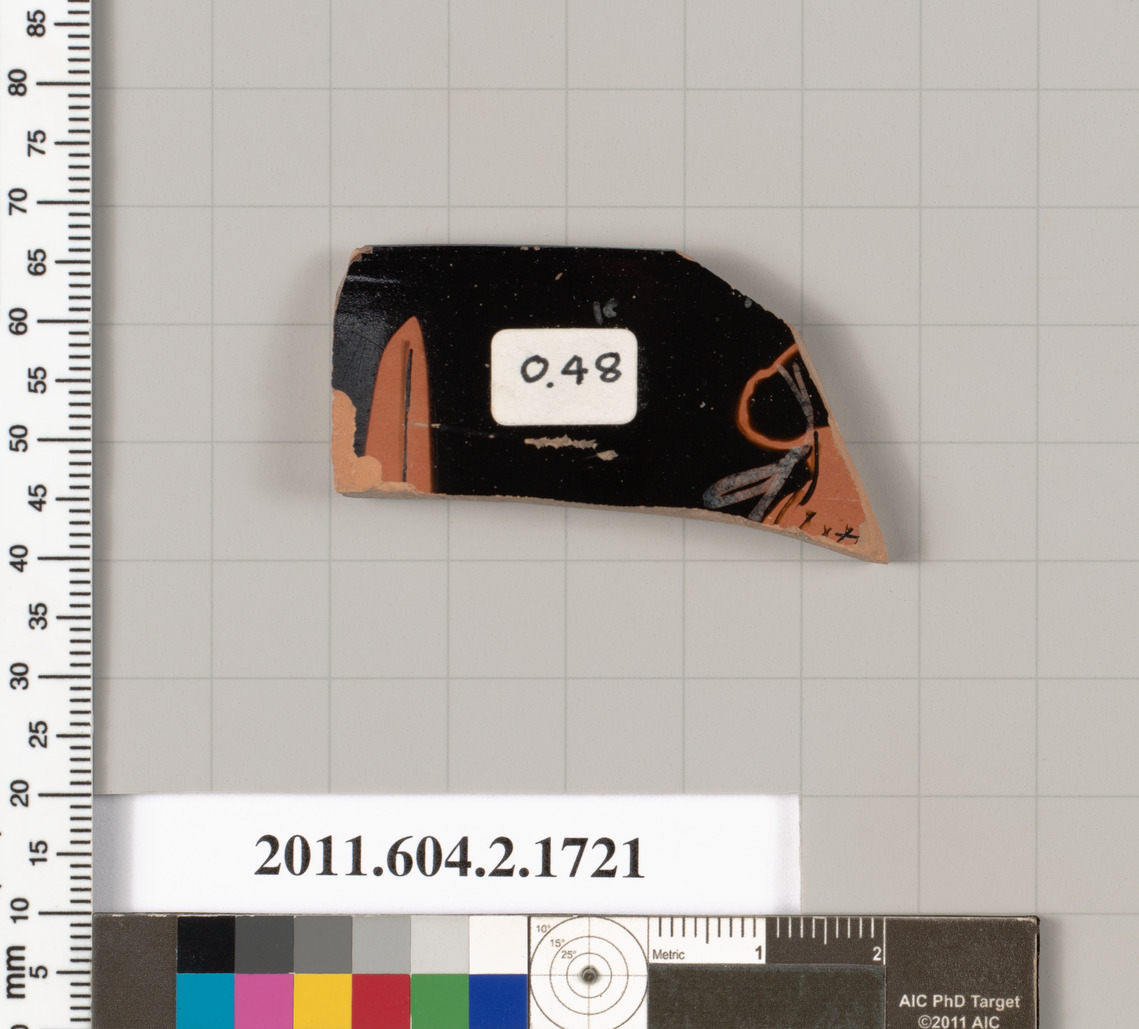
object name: skyphos fragment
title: Terracotta rim fragment of a skyphos (deep drinking cup)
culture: greek, attic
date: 490-470 BCE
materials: terracotta